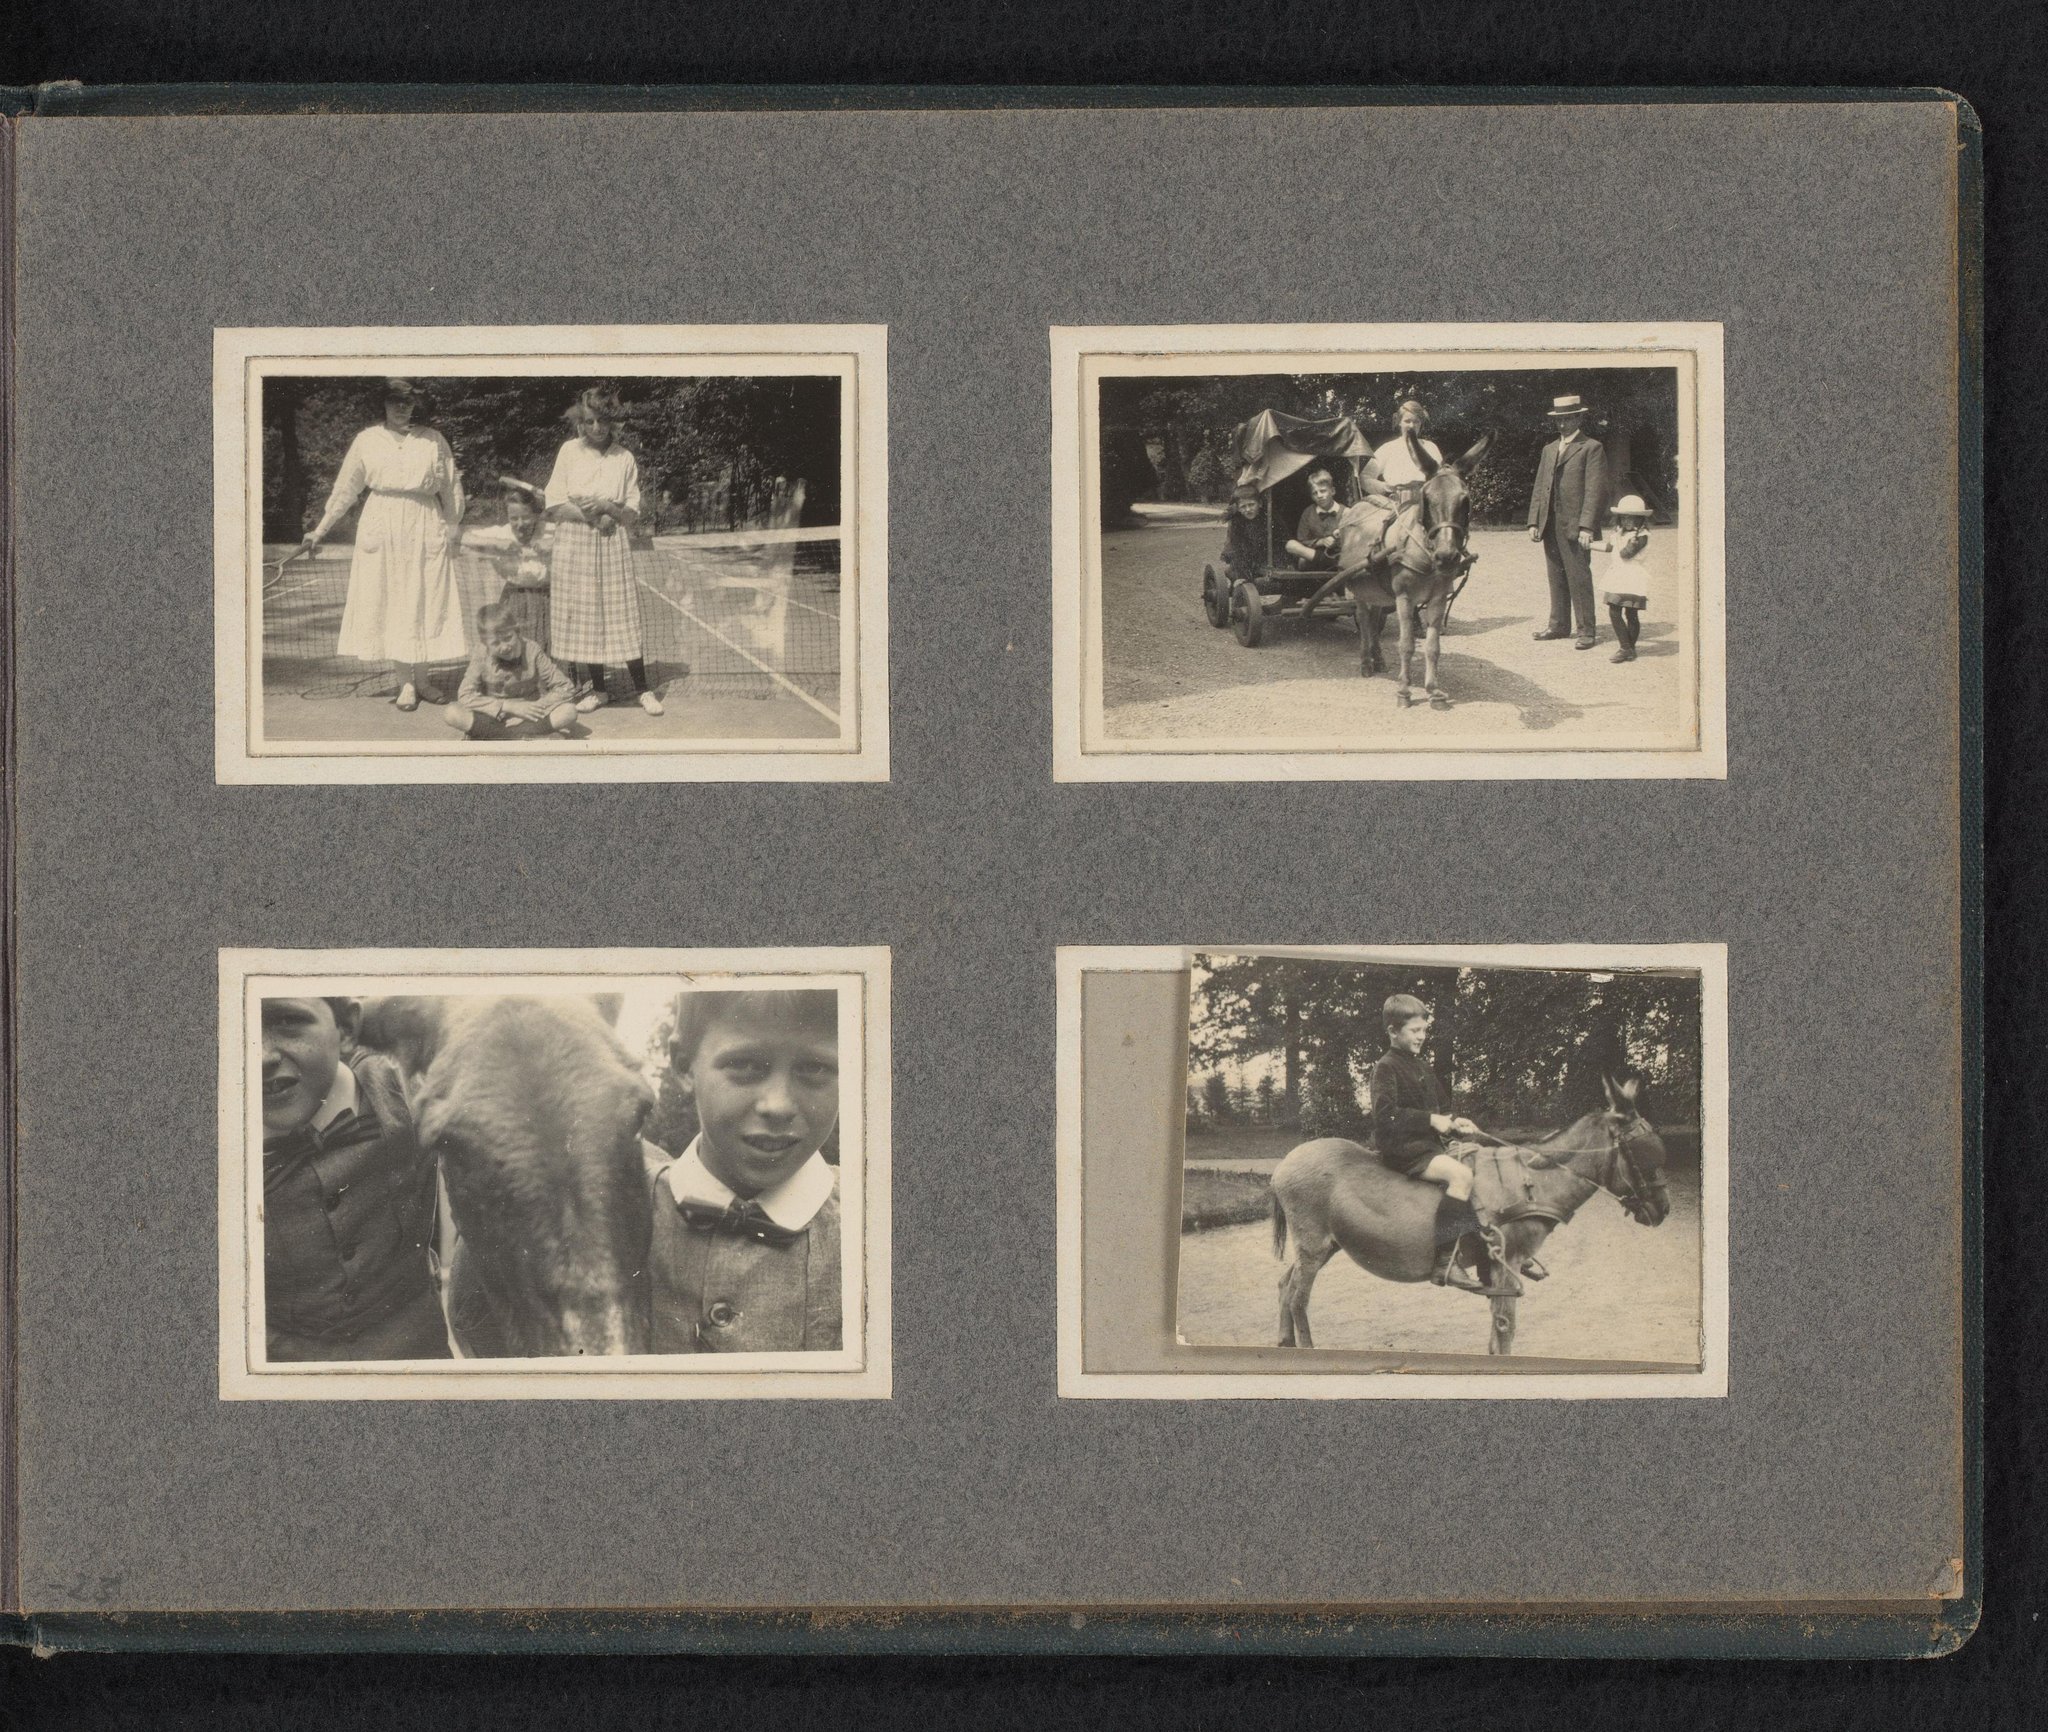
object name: photograph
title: Familie van den Berg op een tennisbaan en tijdens een rit met een ezel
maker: hendrik herman van den berg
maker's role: amateurfotograaf, jurist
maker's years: 1875-1944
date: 1920-1921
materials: paper, cardboard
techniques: gelatin silver print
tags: tennis, lawn-tennis, donkey-riding (on the beach)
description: Deze foto's zijn onderdeel van een album.